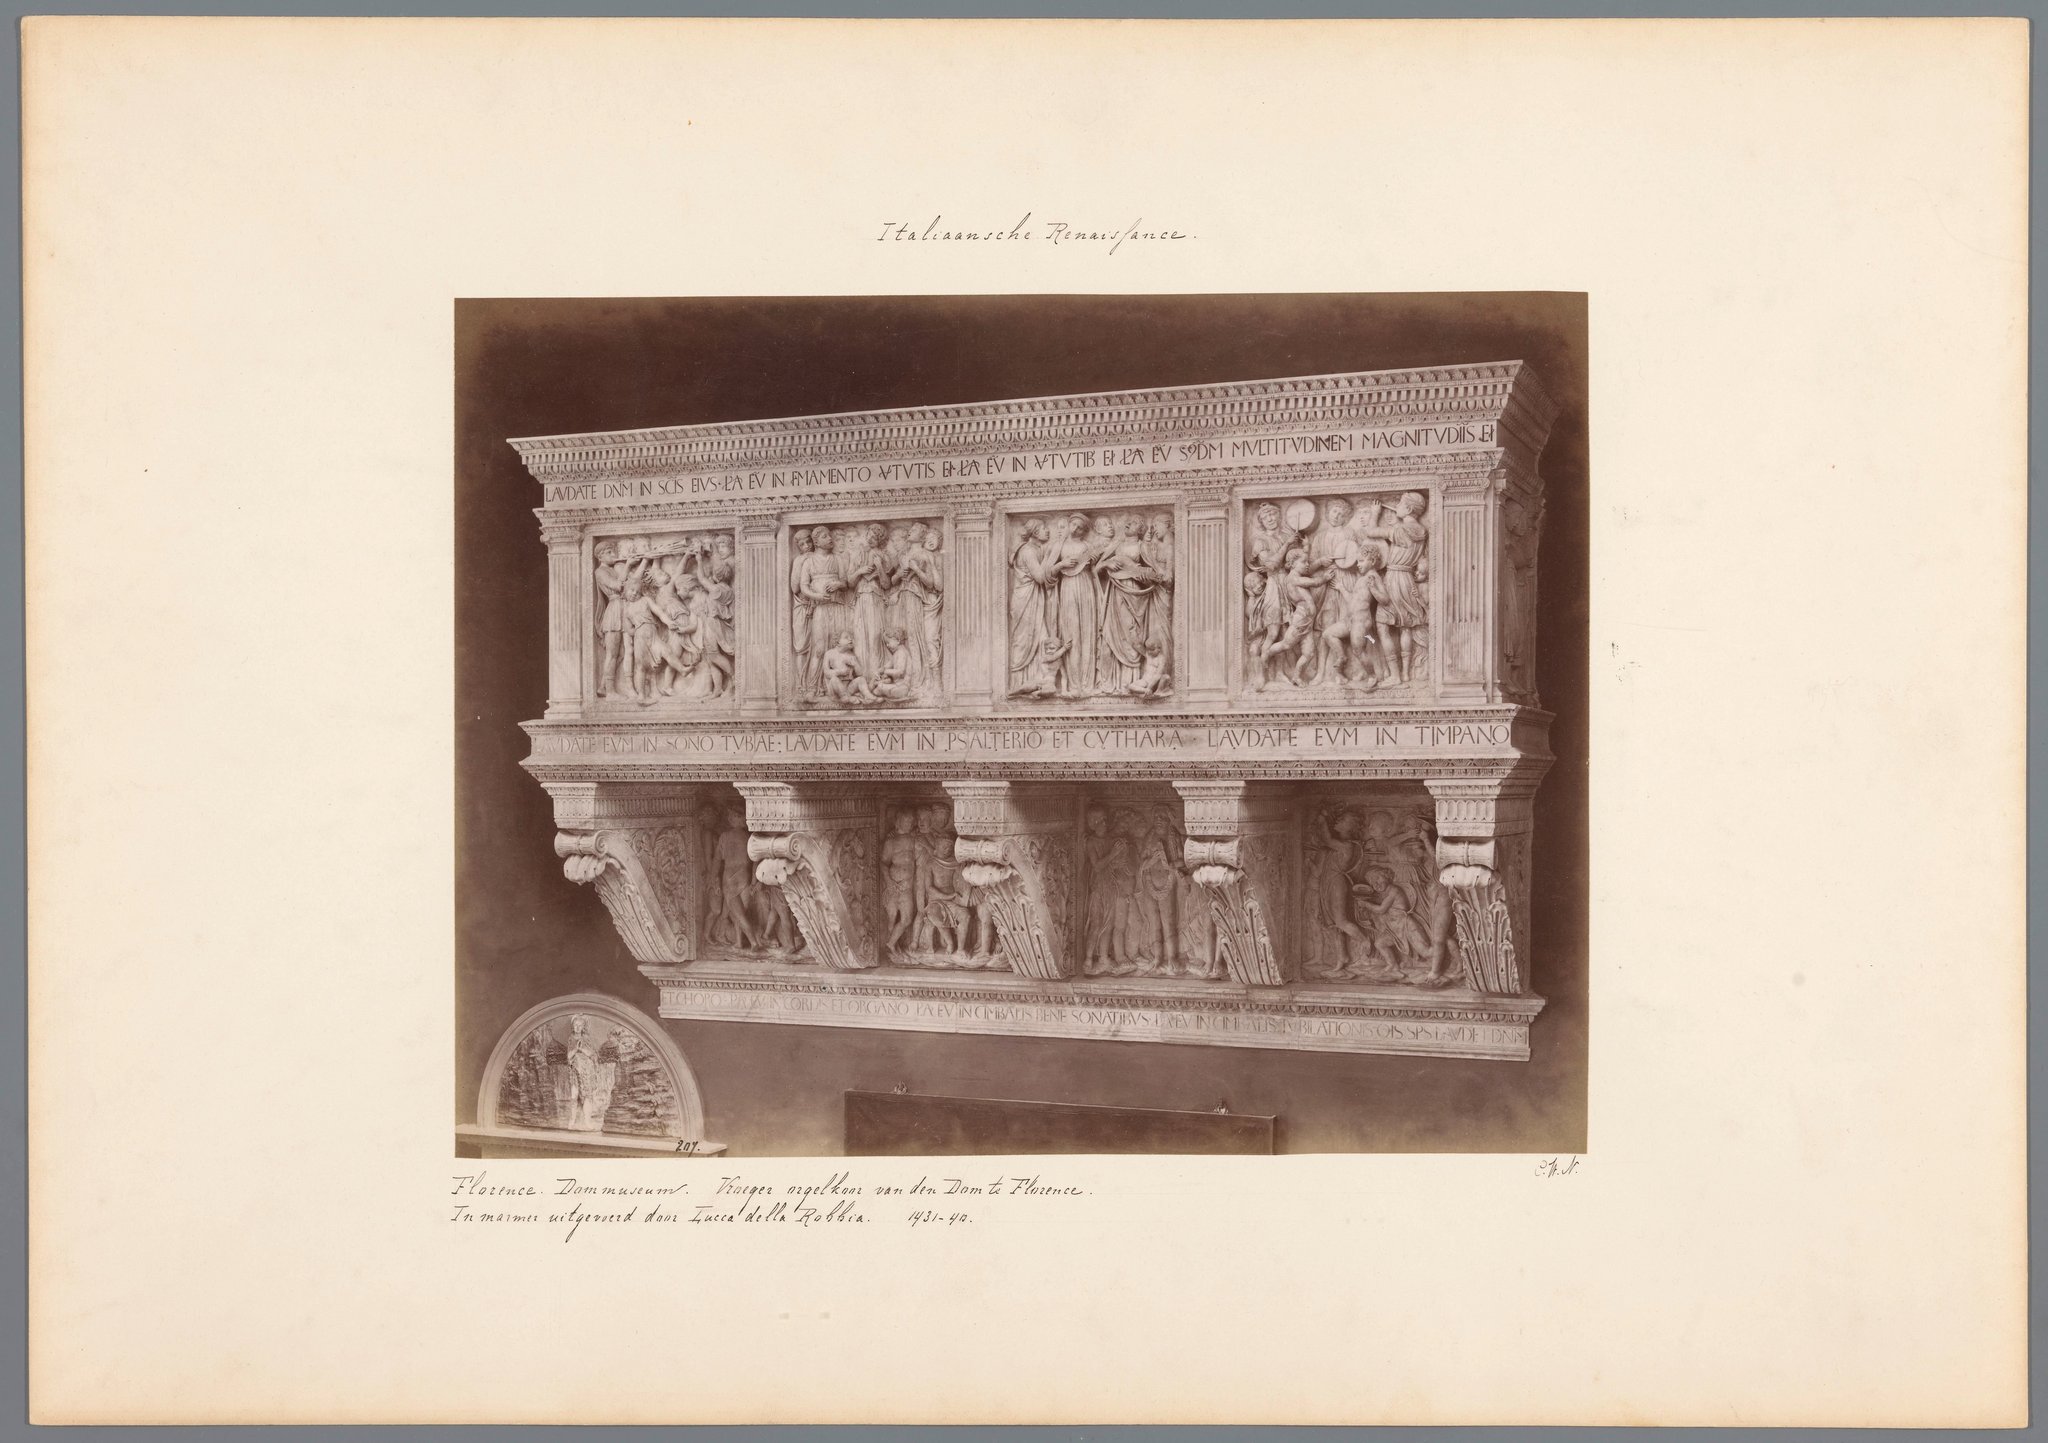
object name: photograph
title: Florence. Dommuseum. Vroeger orgelkoor van den Dom te Florence. In marmer uitgevoerd door Lucca della Robbia. 1431-40.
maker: Anonymous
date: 1875-1900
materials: cardboard, photographic support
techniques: albumen print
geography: europe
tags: pulpit, ambo, chancel, sculpture (+ relief ~ sculpture), europe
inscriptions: collector's mark: ‘KUNSTNIJVERHEIDSCHOOL QUELLINUS AMSTERDAM FRANS HALSSTRAAT 14.’, number: ‘207.’, collector's mark: ‘INSTITUUT VOOR KUNST-NIJVERHEIDSONDERWIJS GABRIËL METSUSTRAAT No. 16 AMSTERDAM’, inscription: ‘Italiaansche Renaissance.’, inscription: ‘C.W.N.’